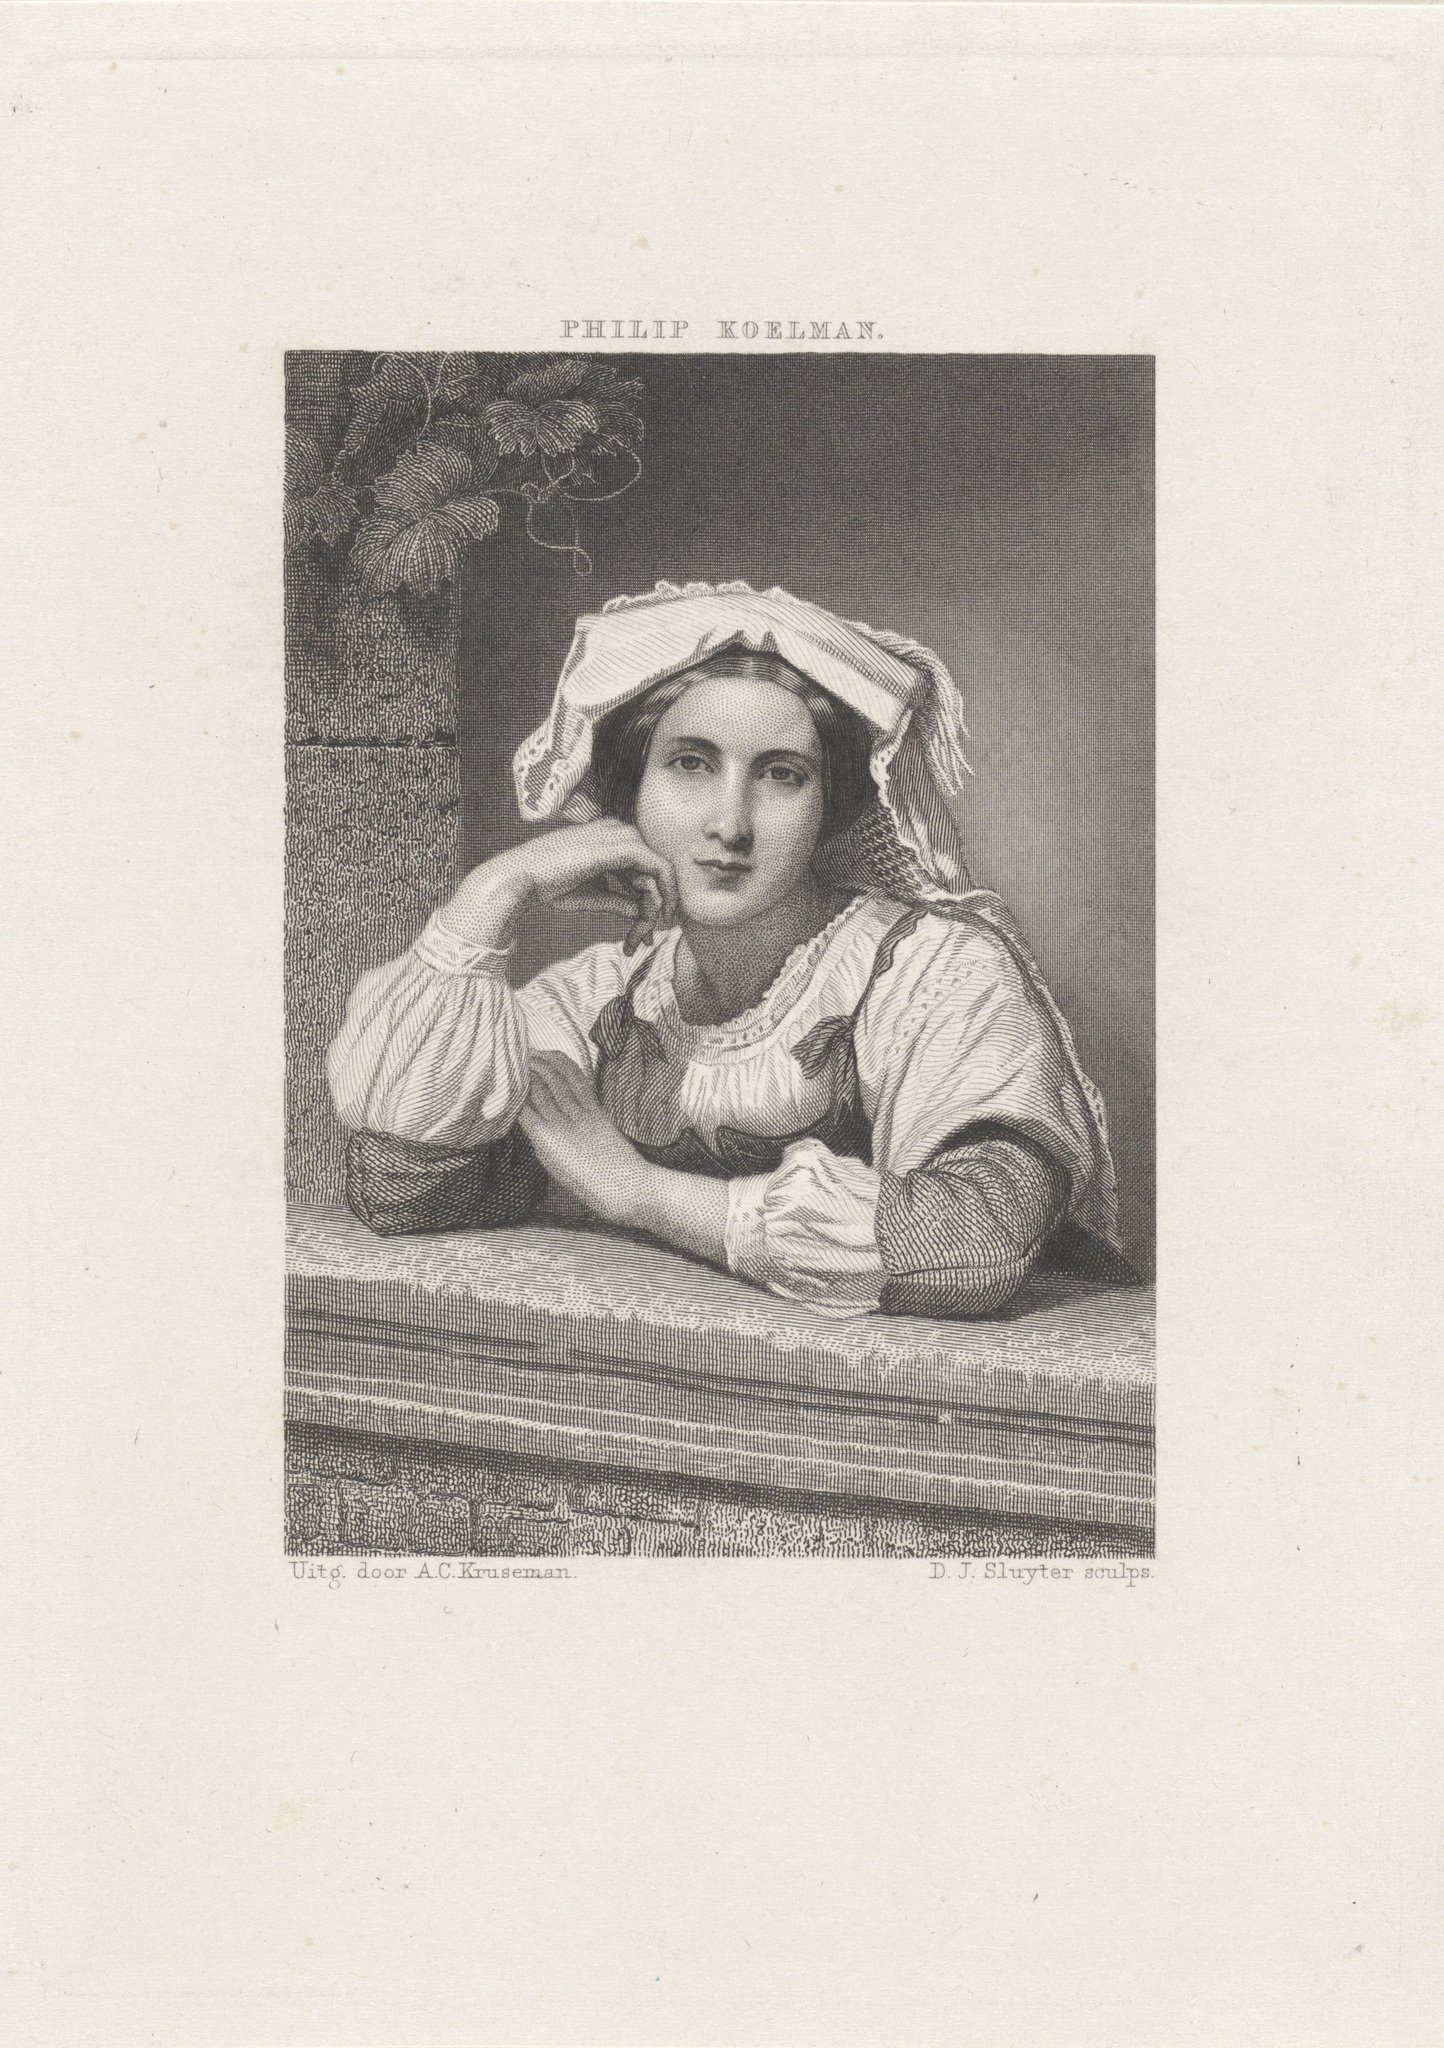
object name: print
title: Jonge vrouw met muts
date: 1859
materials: paper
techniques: etching, engraving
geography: haarlem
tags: adolescent, young woman, maiden, head-gear: cap (+ women's clothes)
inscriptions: collector's mark: Lugt 2228, inscription: ‘Uit Aurora 1859.’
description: Een jonge vrouw leunt uit een raam op een brede vensterbank. Zij draagt een kanten muts met sluier. Boven haar hoofd een wijnrank. Naar het schilderij "De Italiane"van Johan Philip Koelman.